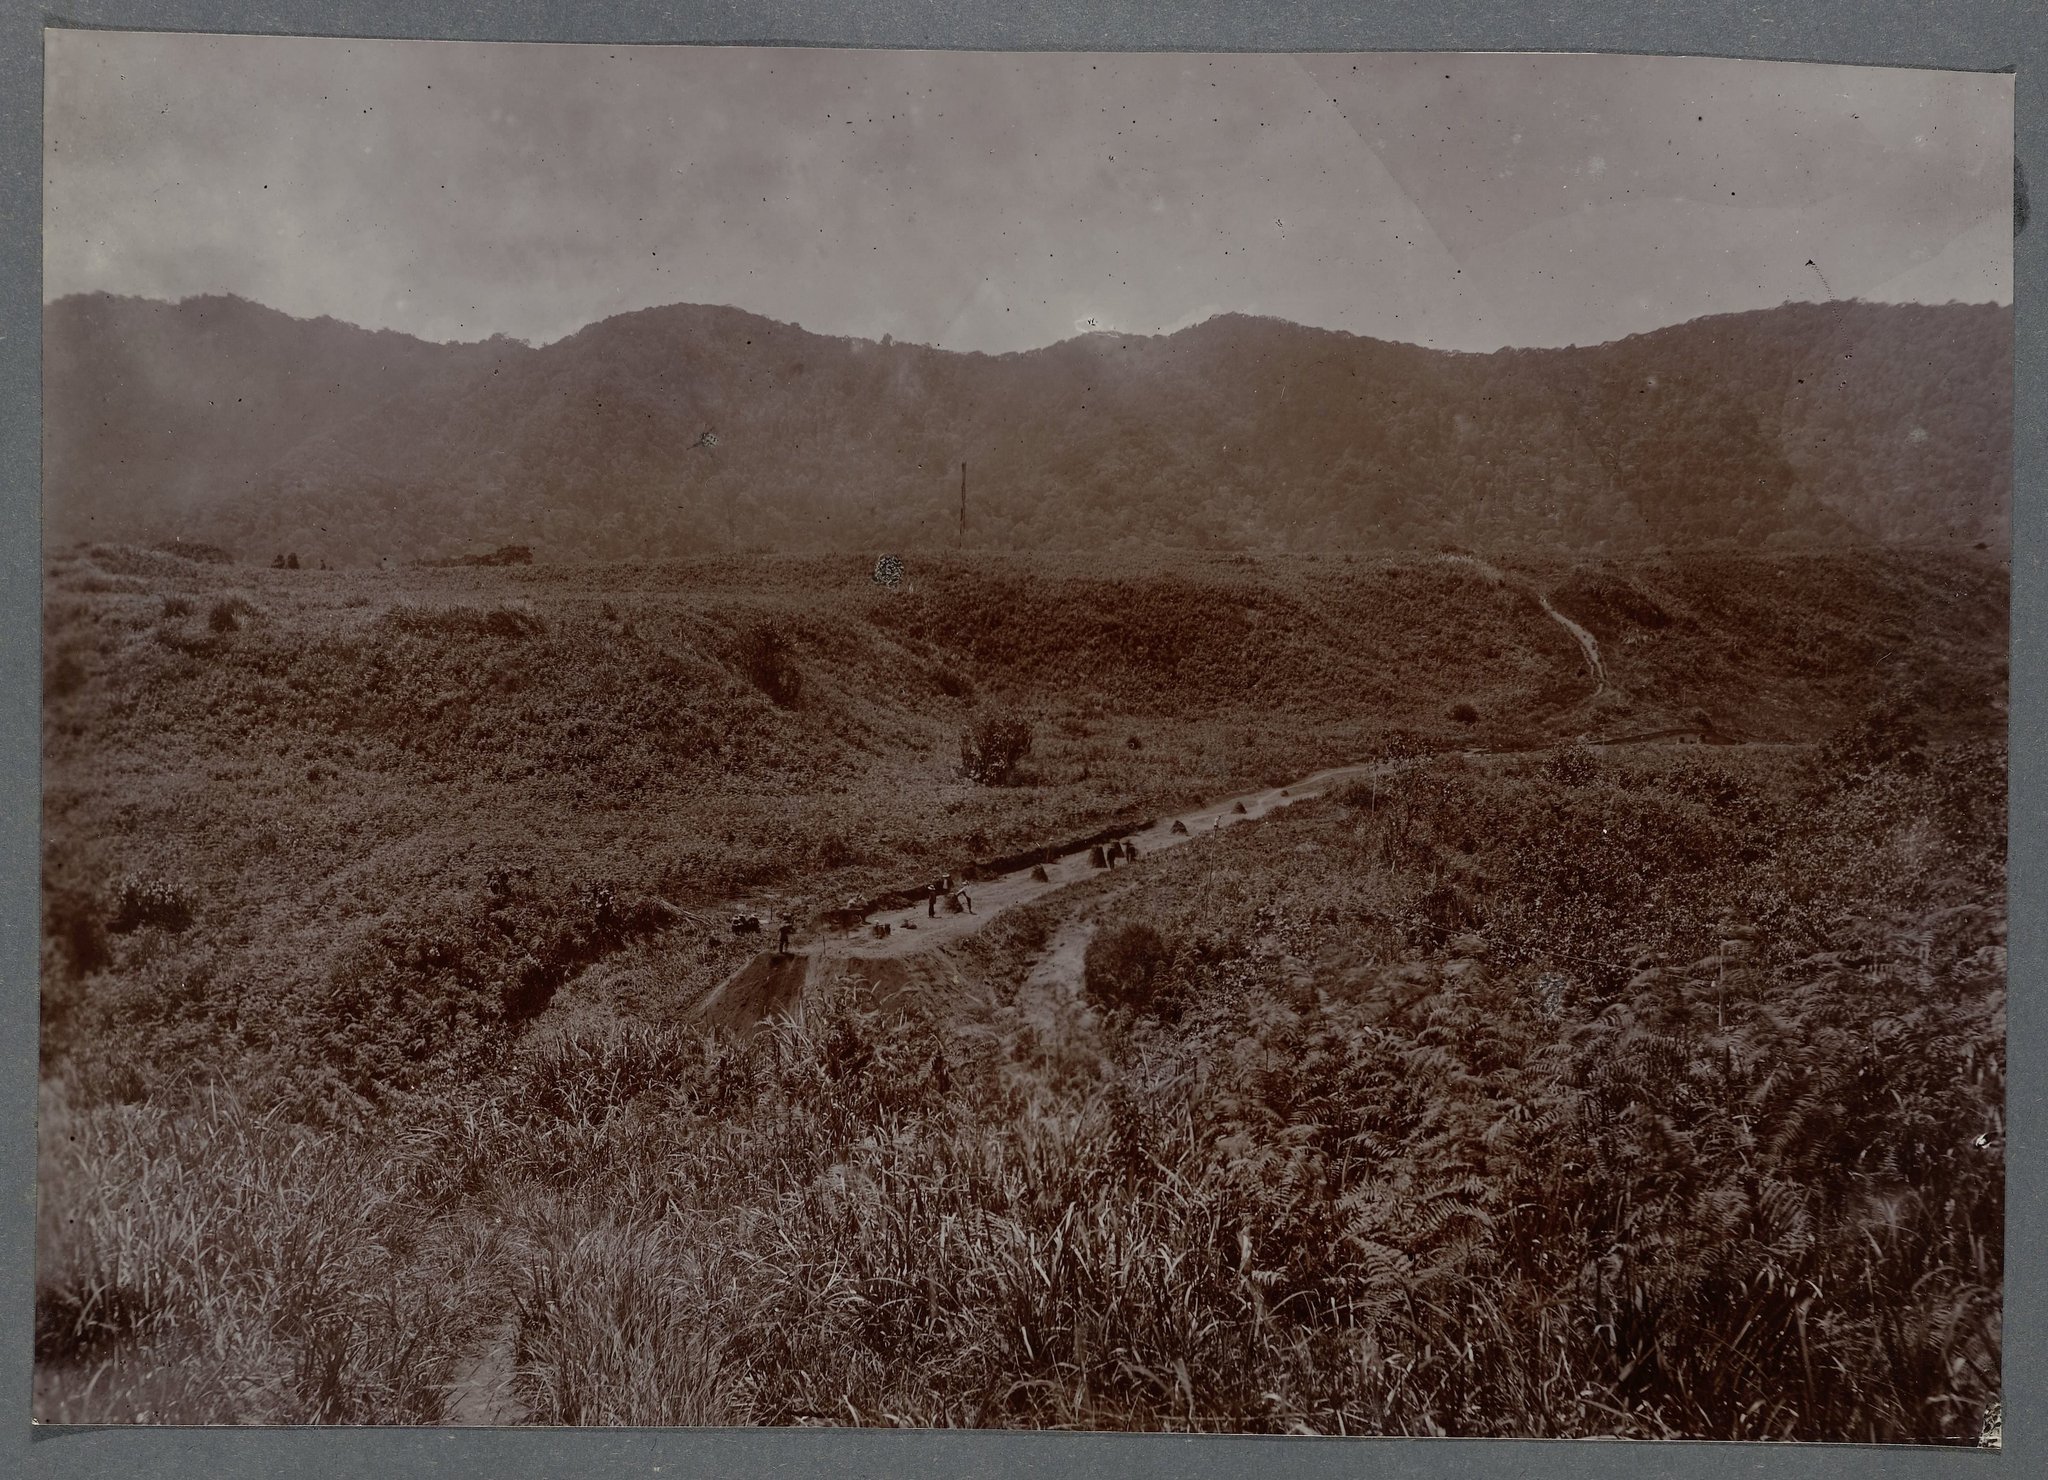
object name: photograph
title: Aanleg van de weg door open terrein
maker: Anonymous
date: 1903-1913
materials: photographic support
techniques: gelatin silver print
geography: north sumatra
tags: arnhem, albertus dominicus laman trip, building activities, traffic by road or path with motor-vehicle, landscapes in tropical and sub-tropical regions, road, path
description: Na de expedities naar de Gajo- en Alaslanden o.l.v. Van Daalen (eerste tocht in 1901), werd hij in 1903 belast met voorbereiding van permanente vestiging van Nederlands gezag. Aanleg van een weg van de Noordkust naar het binnenland was hierbij van groot belang. Deze zgn. Gajoweg werd aangelegd tussen 1903 en 1914, van Bireuen aan de kust naar Takinguen aan het bergmeer Danau Lauttawar, totale lengte 104 km.